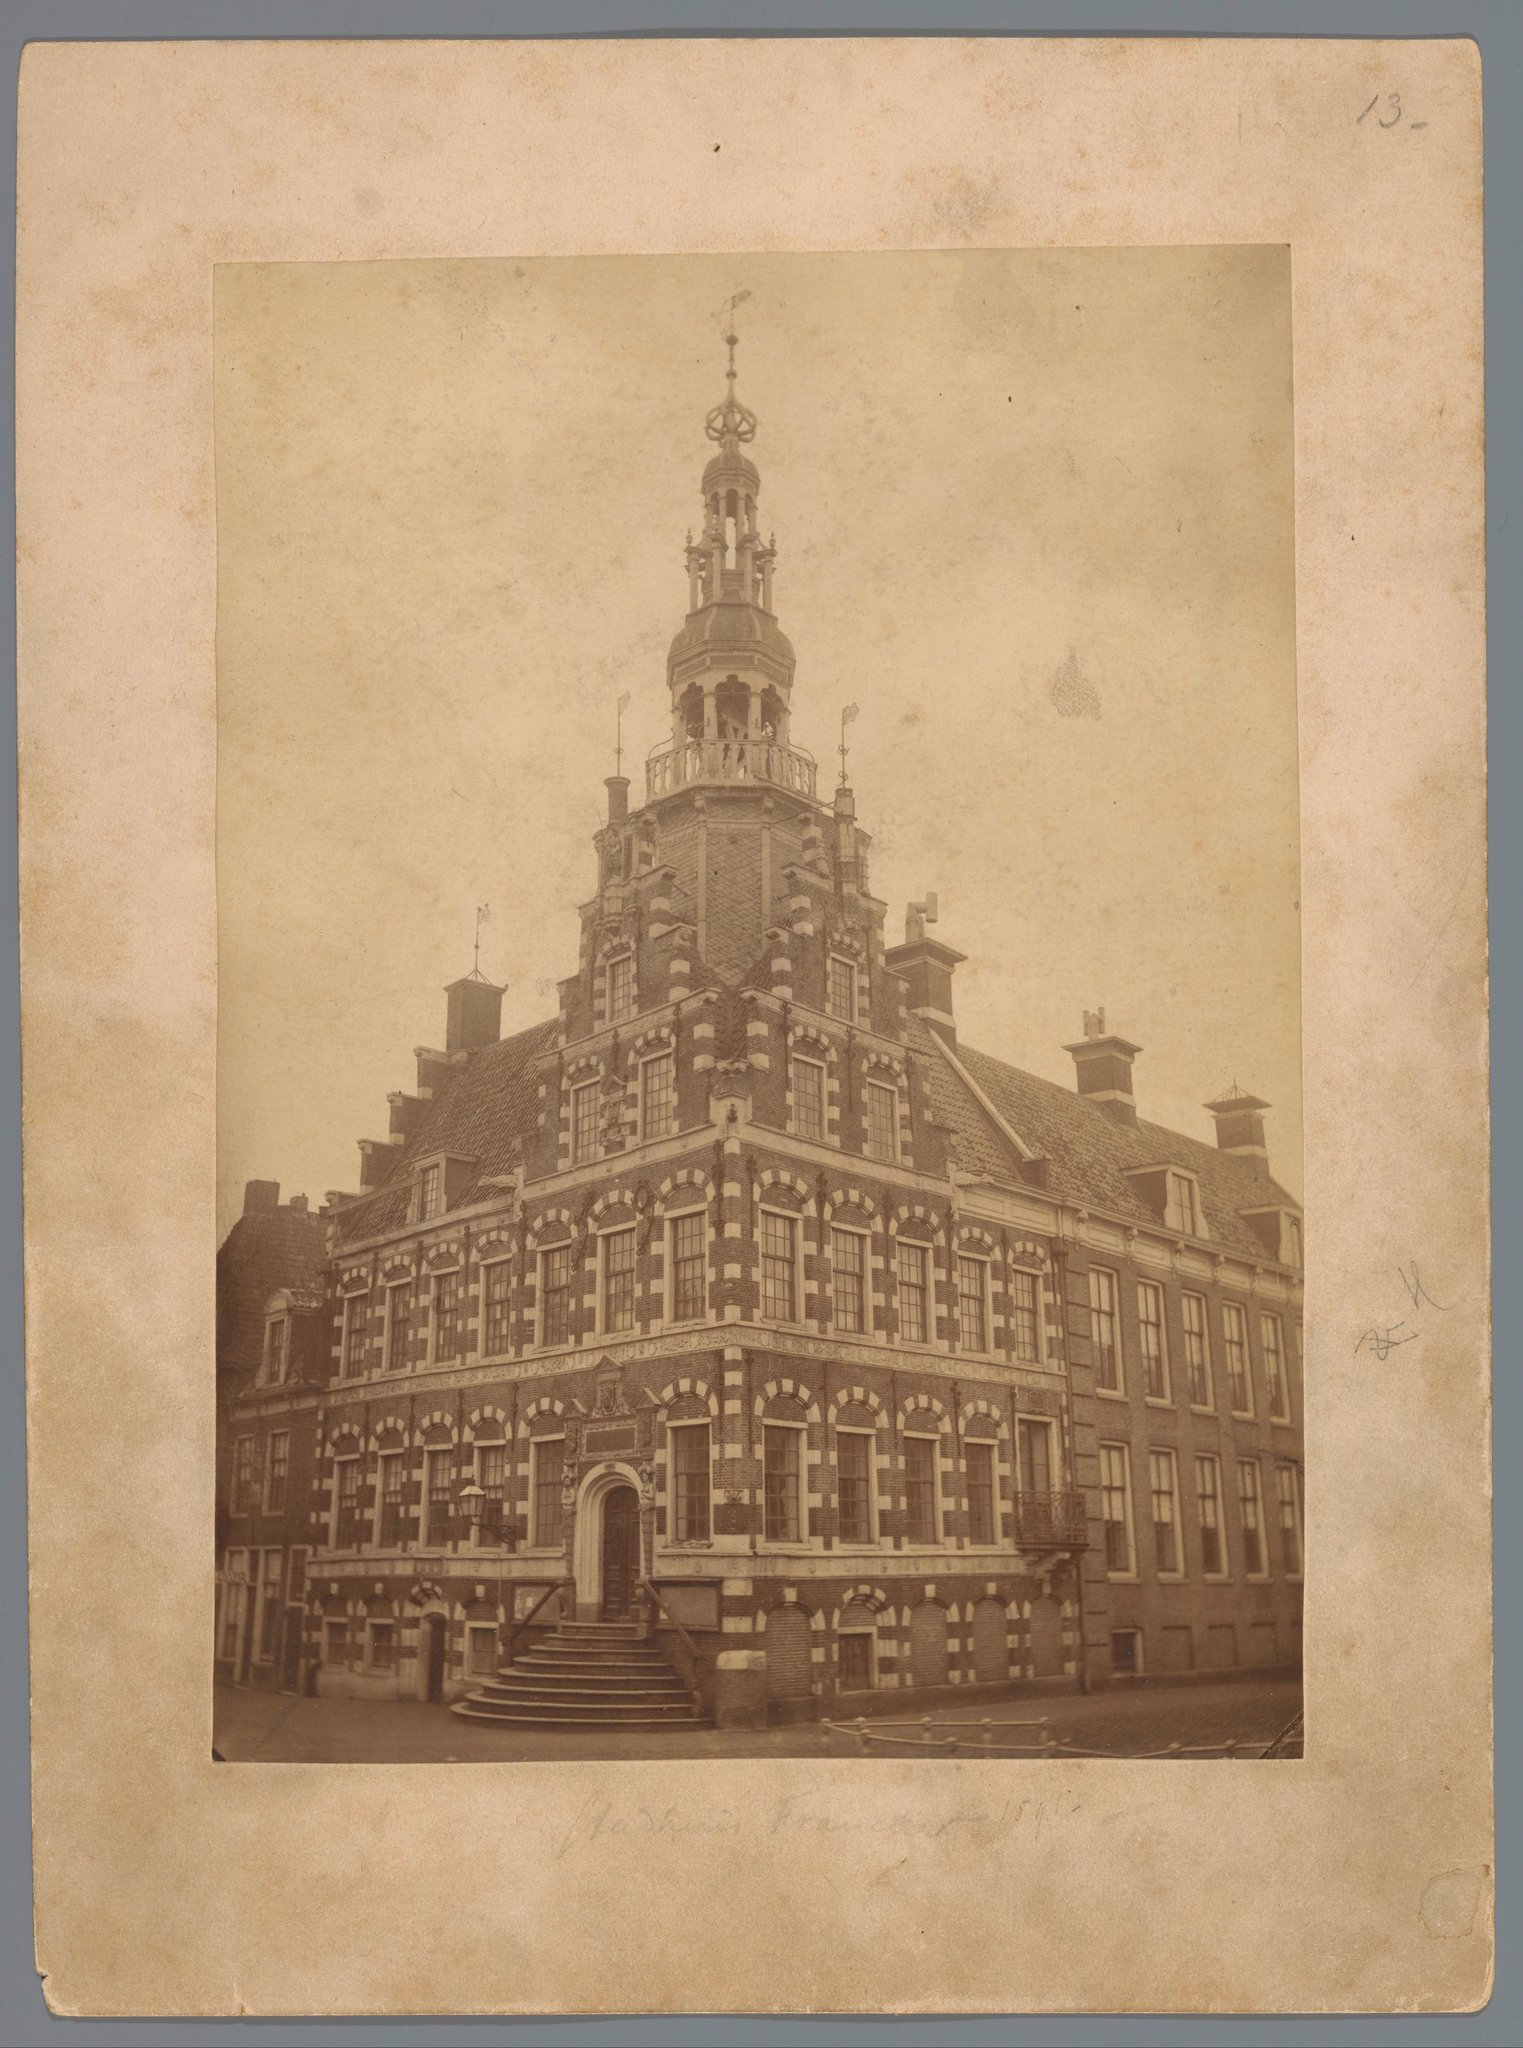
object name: photograph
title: Exterieur van het stadhuis van Franeker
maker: a. visser jzn.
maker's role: fotograaf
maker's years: 1847-1926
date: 1875-1900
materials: cardboard, photographic support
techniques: albumen print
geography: franeker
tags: townhall, façade (of house or building)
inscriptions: inscription: ‘Stadhuis Franeker 1591’, collector's mark: Lugt 3937, name: ‘A. Visser Jz. Photograaf Franeker’